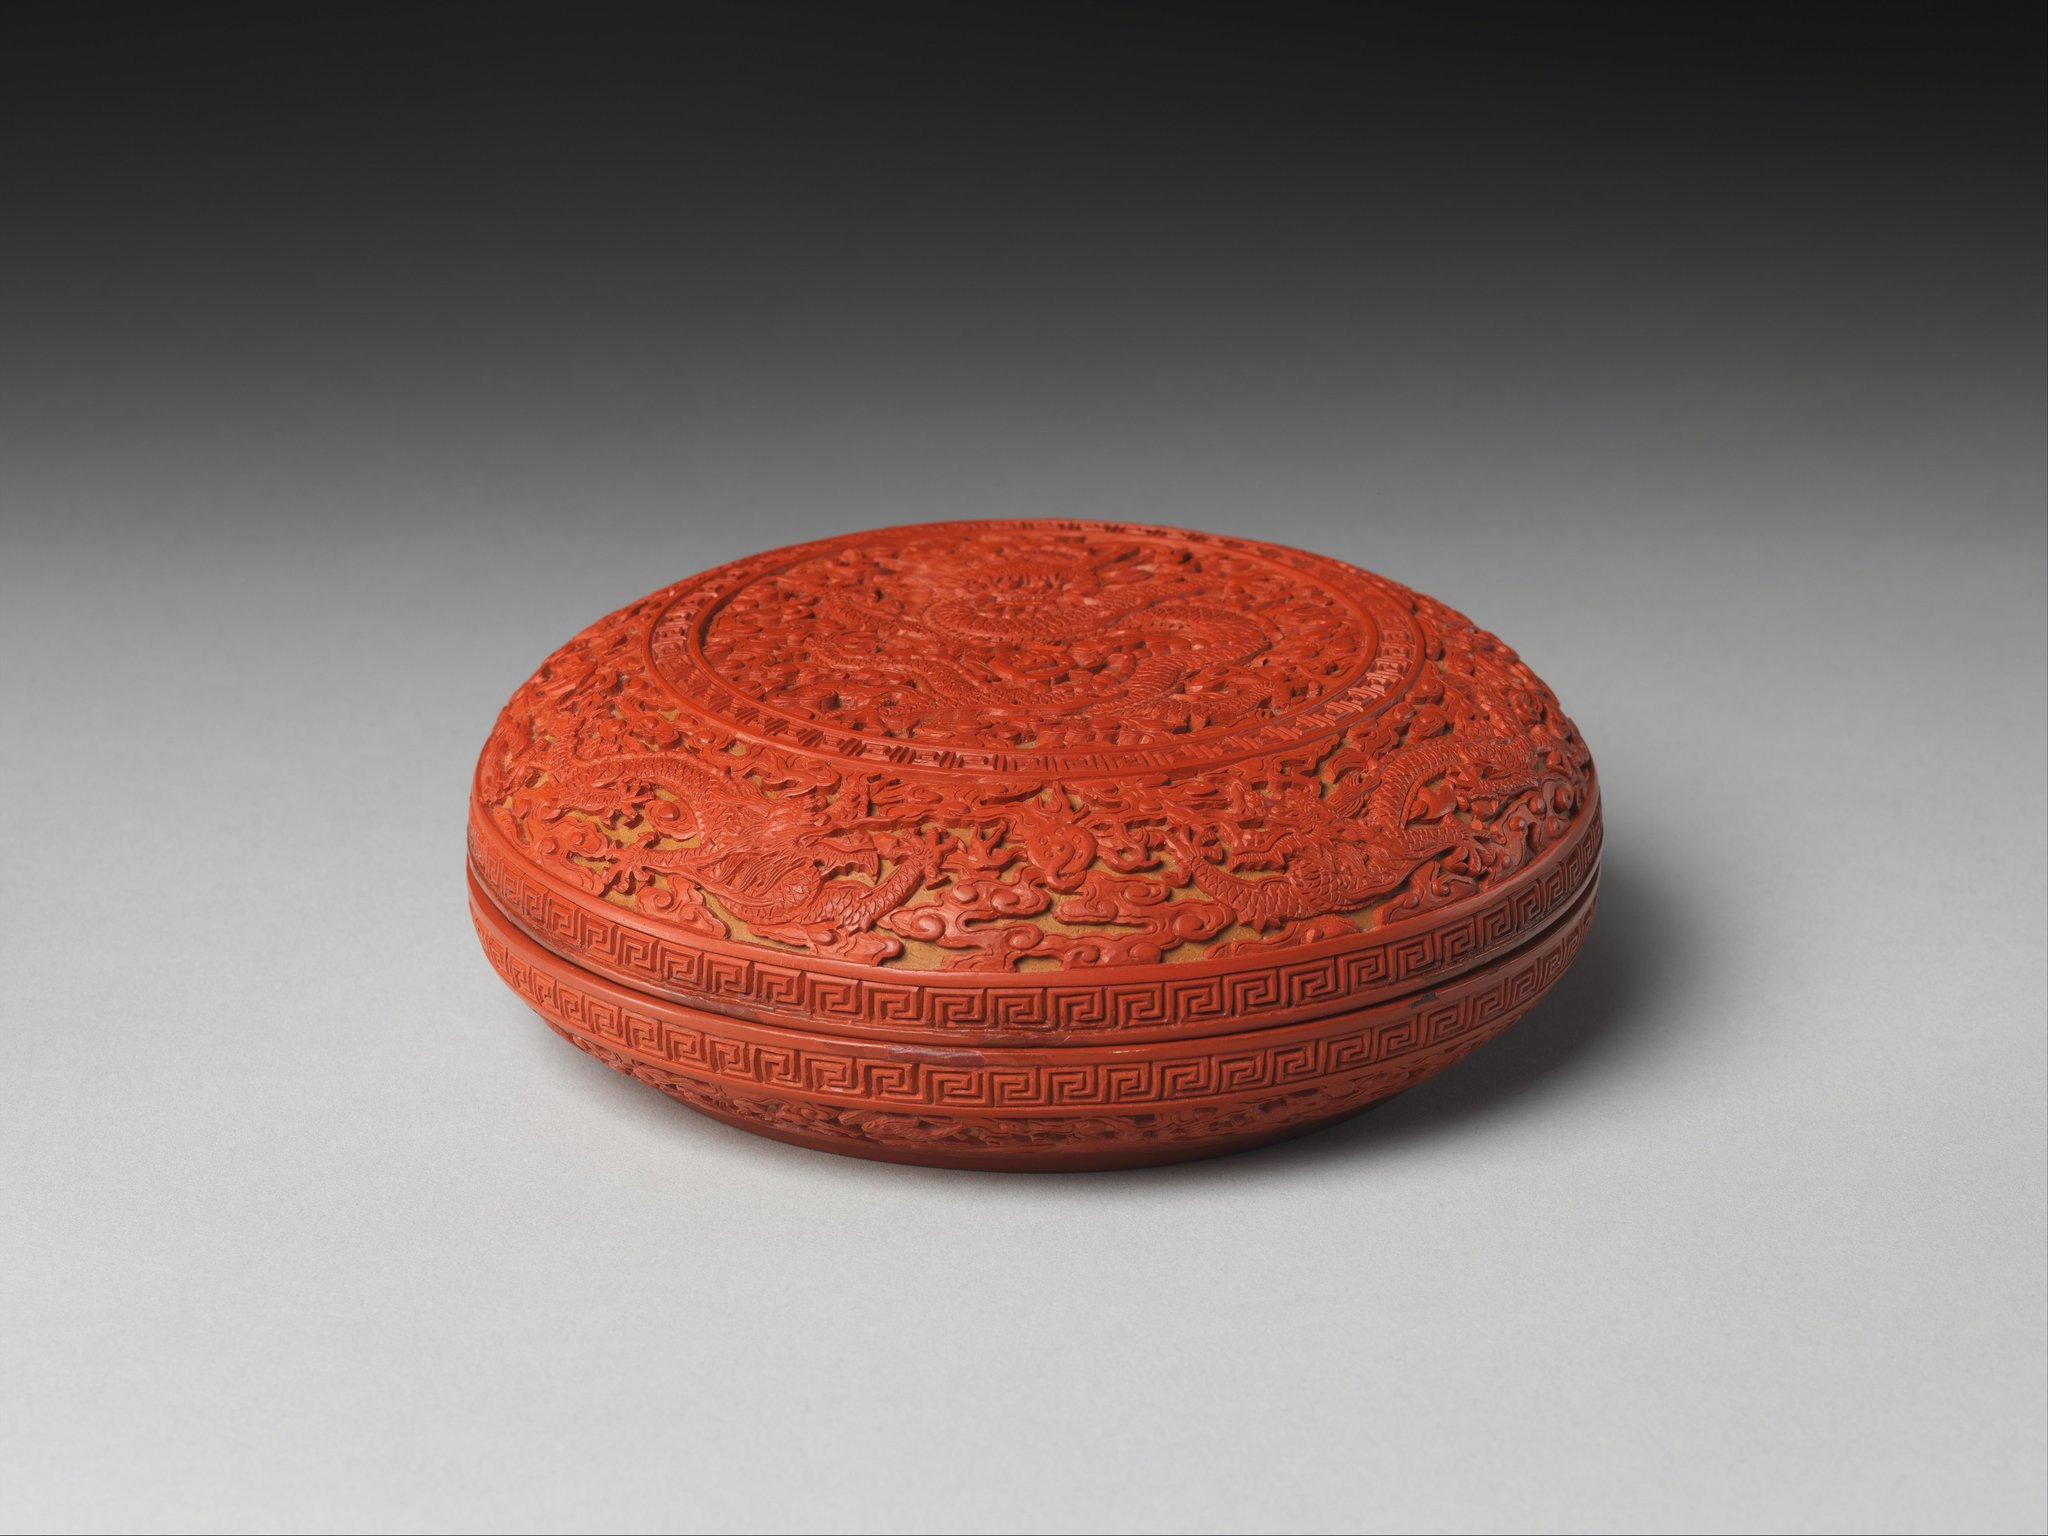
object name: box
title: Box with dragons in clouds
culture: chinese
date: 1734-1766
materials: lacquer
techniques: carving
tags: dragons